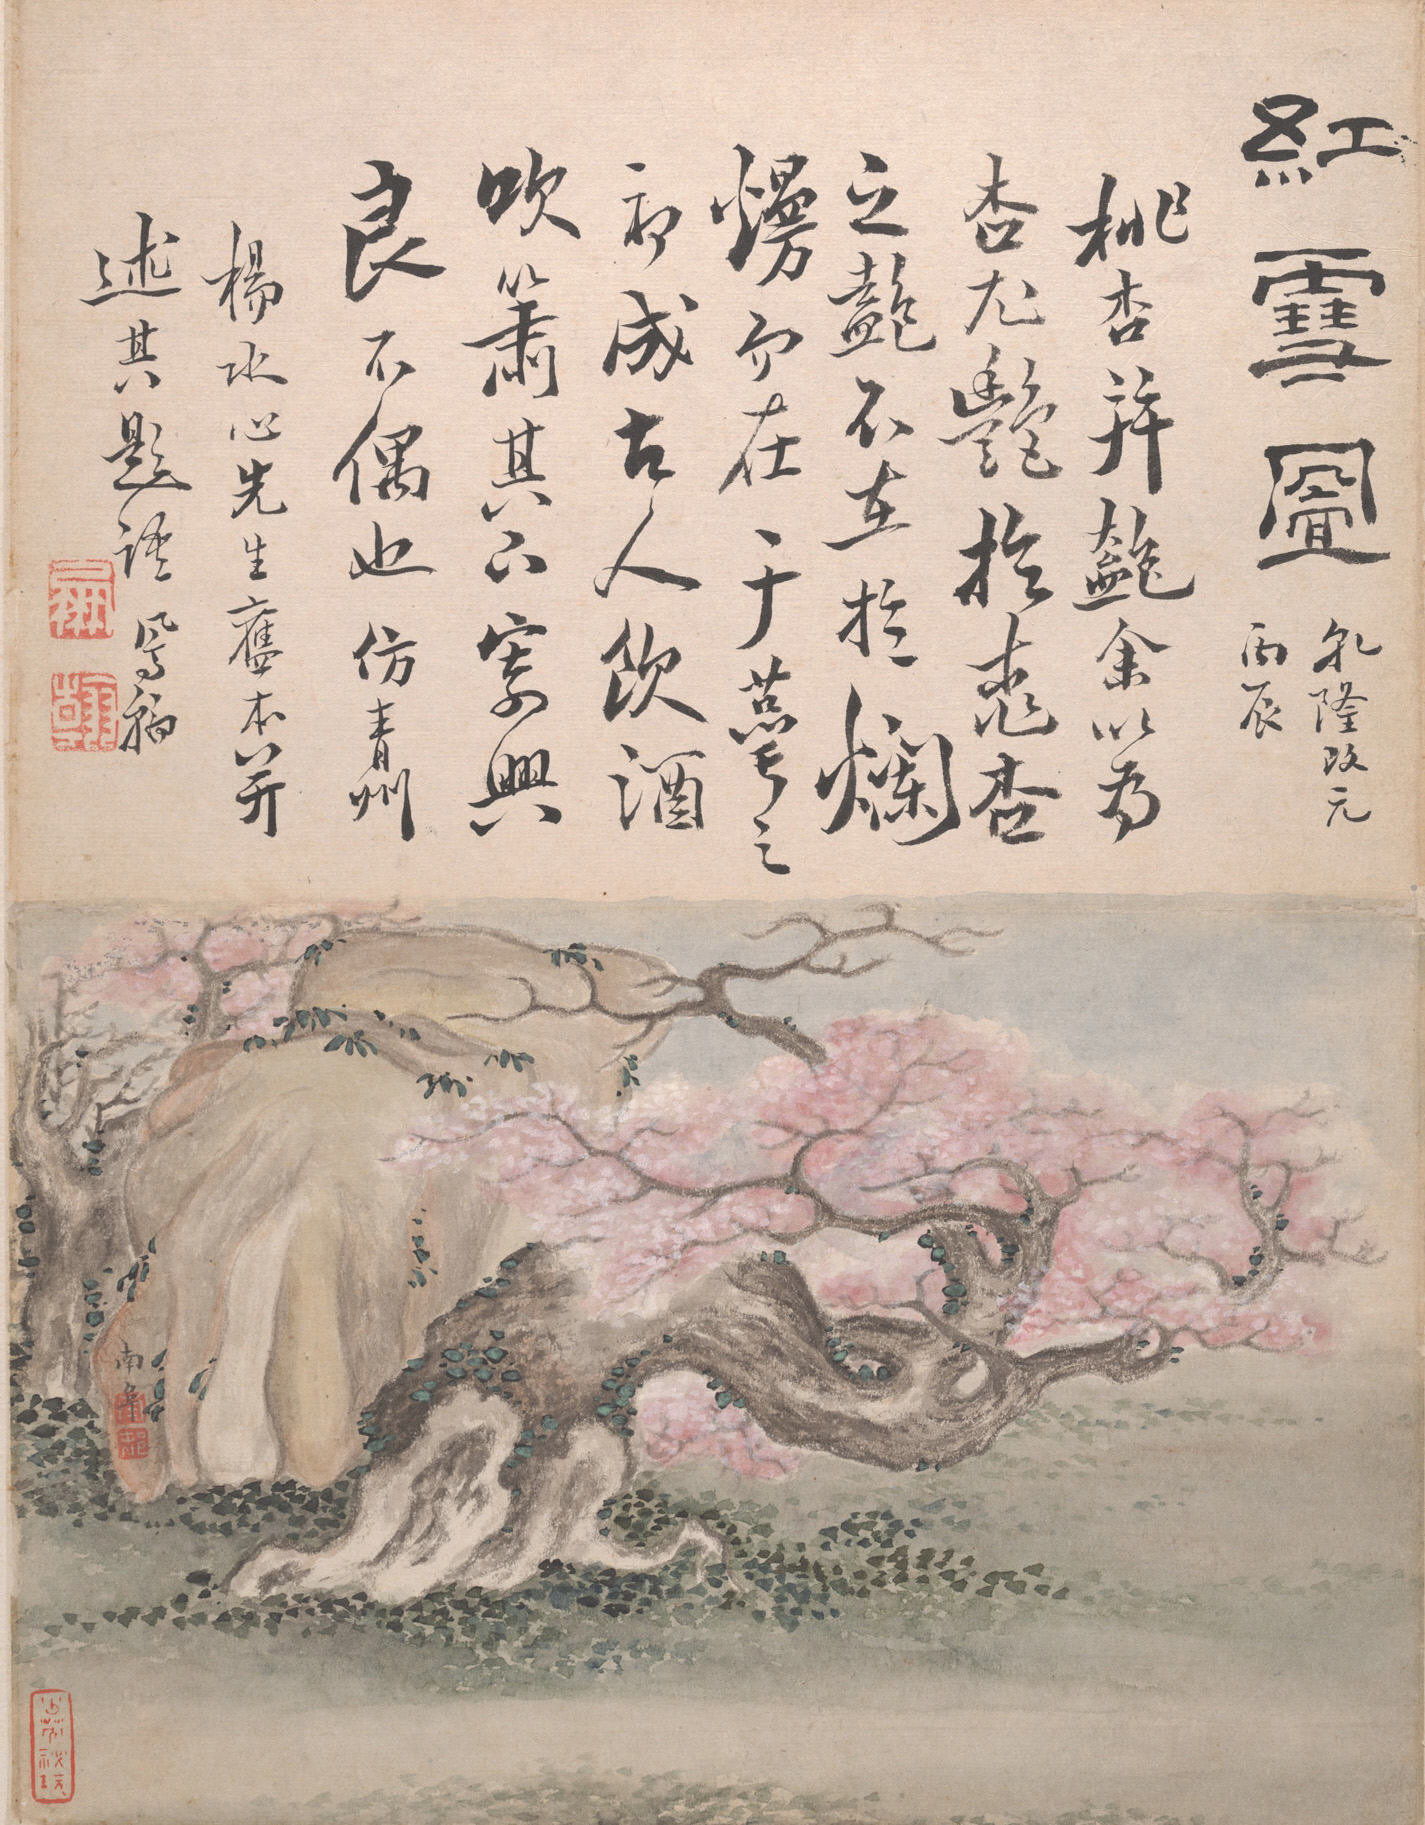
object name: album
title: Landscapes and calligraphy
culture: chinese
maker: gao fenghan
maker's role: artist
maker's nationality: chinese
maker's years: 1683-1748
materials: ink, paper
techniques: painting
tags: landscapes,calligraphy